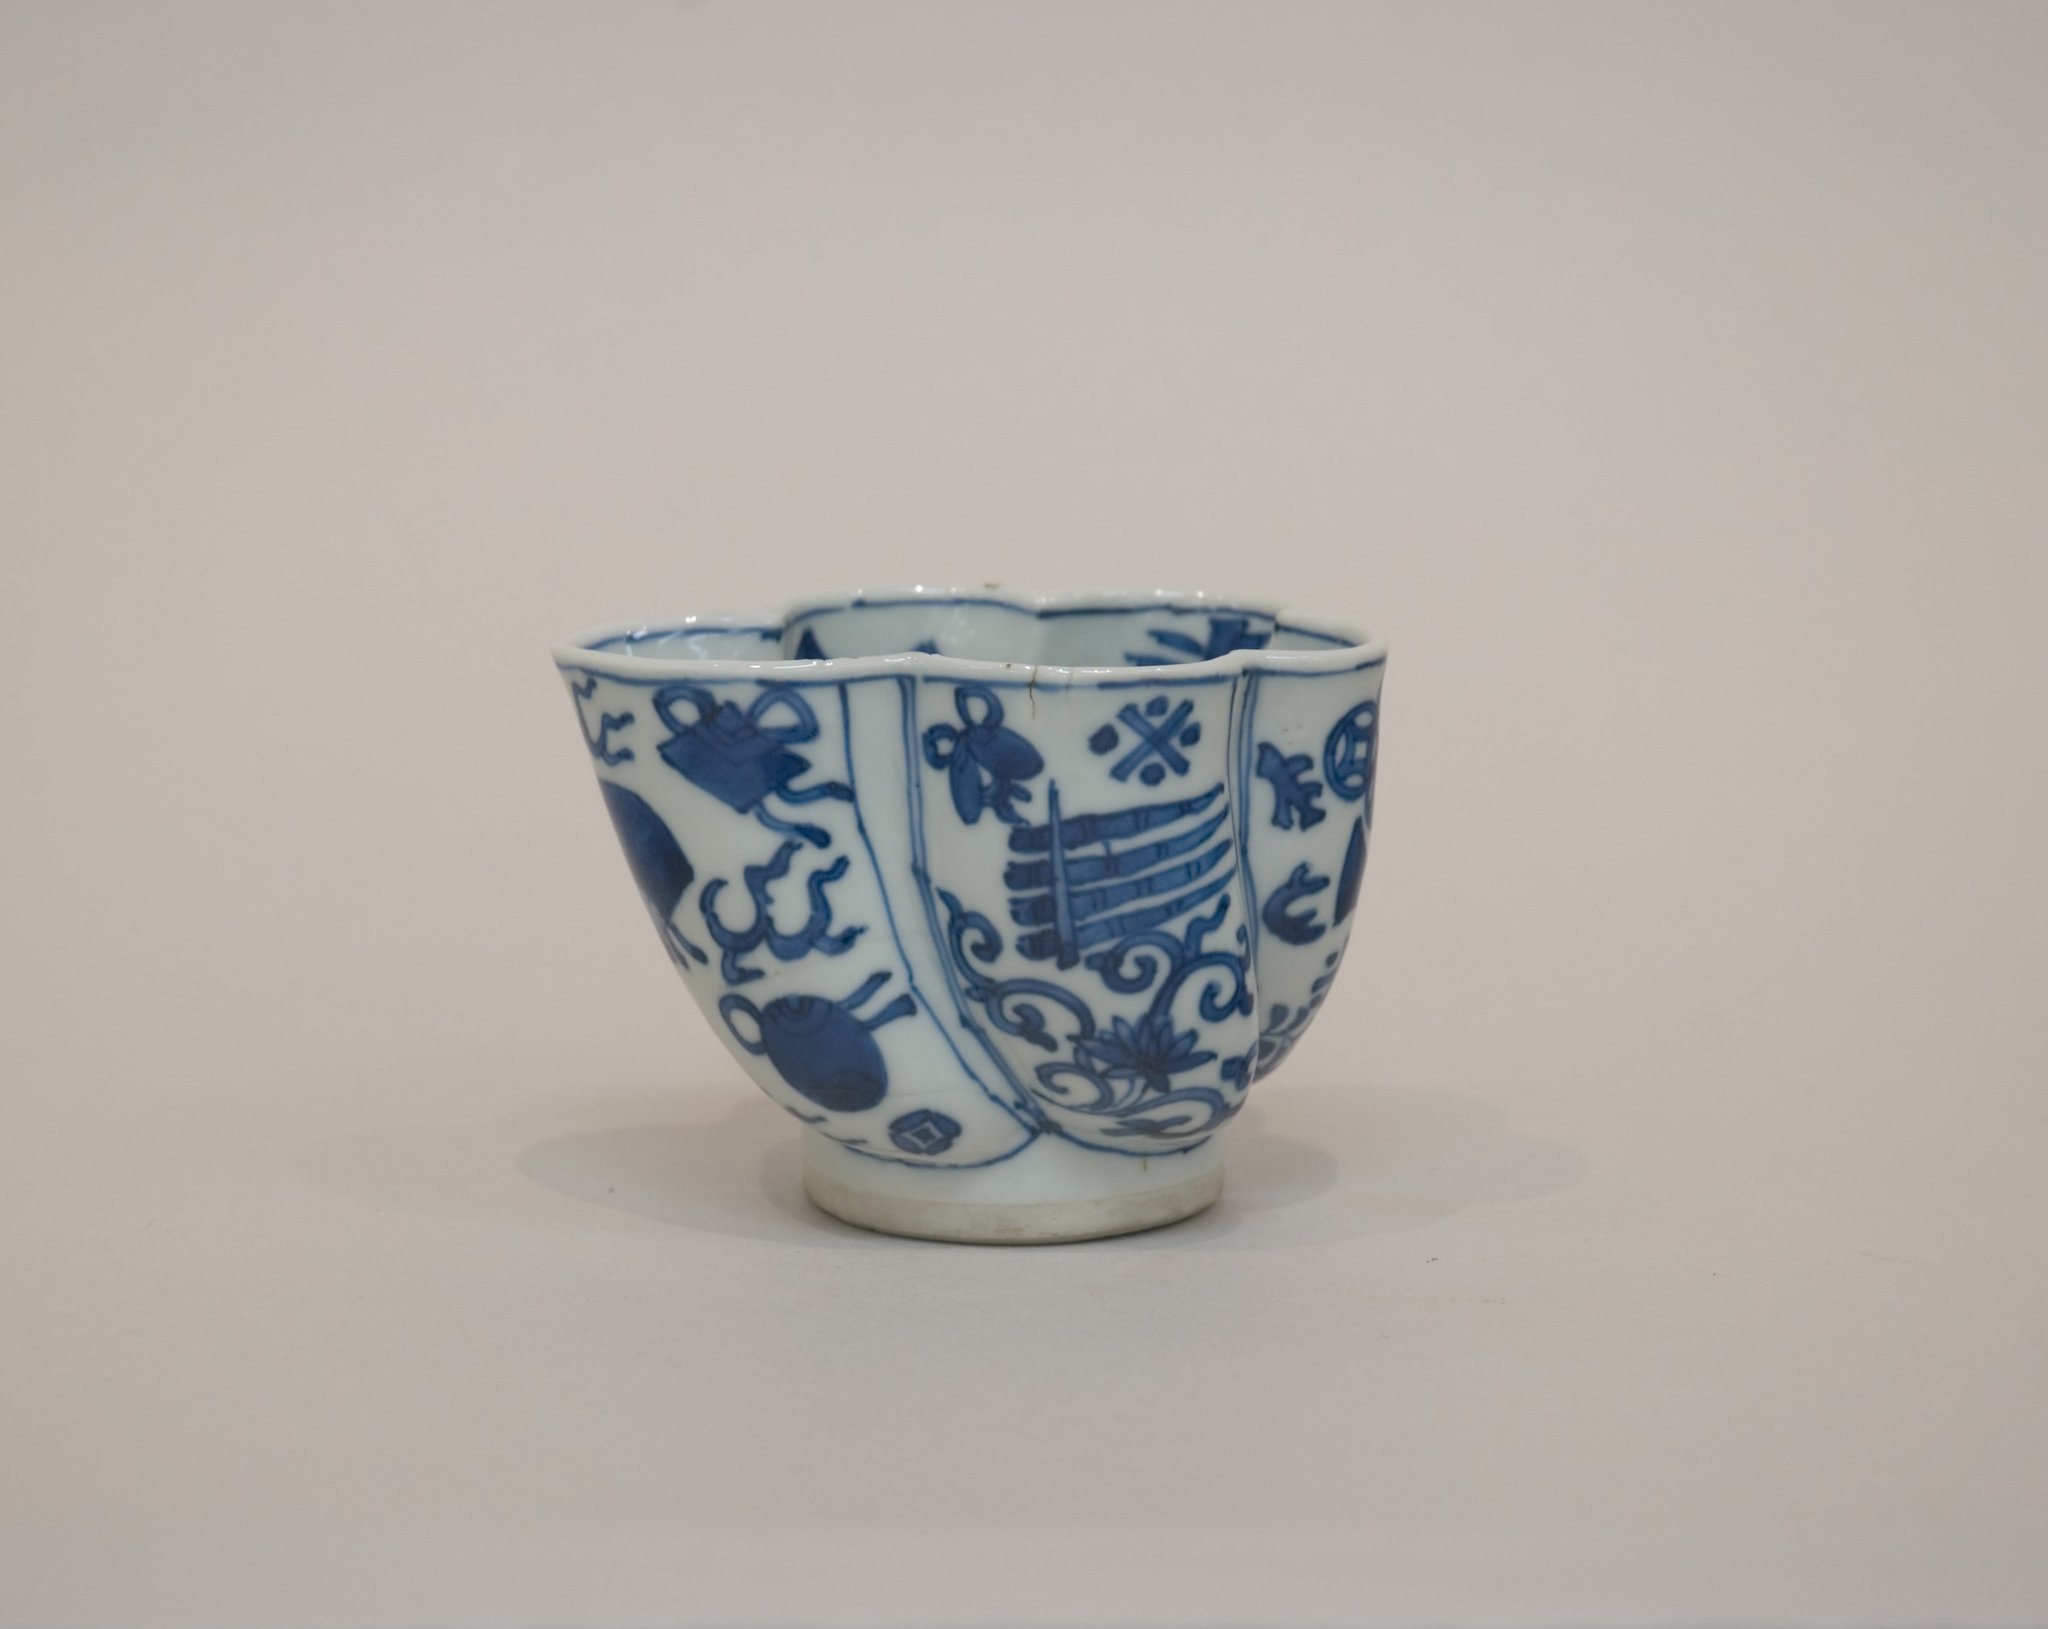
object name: cup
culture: chinese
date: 1567-1633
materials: porcelain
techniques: painting, underglaze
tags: flowers